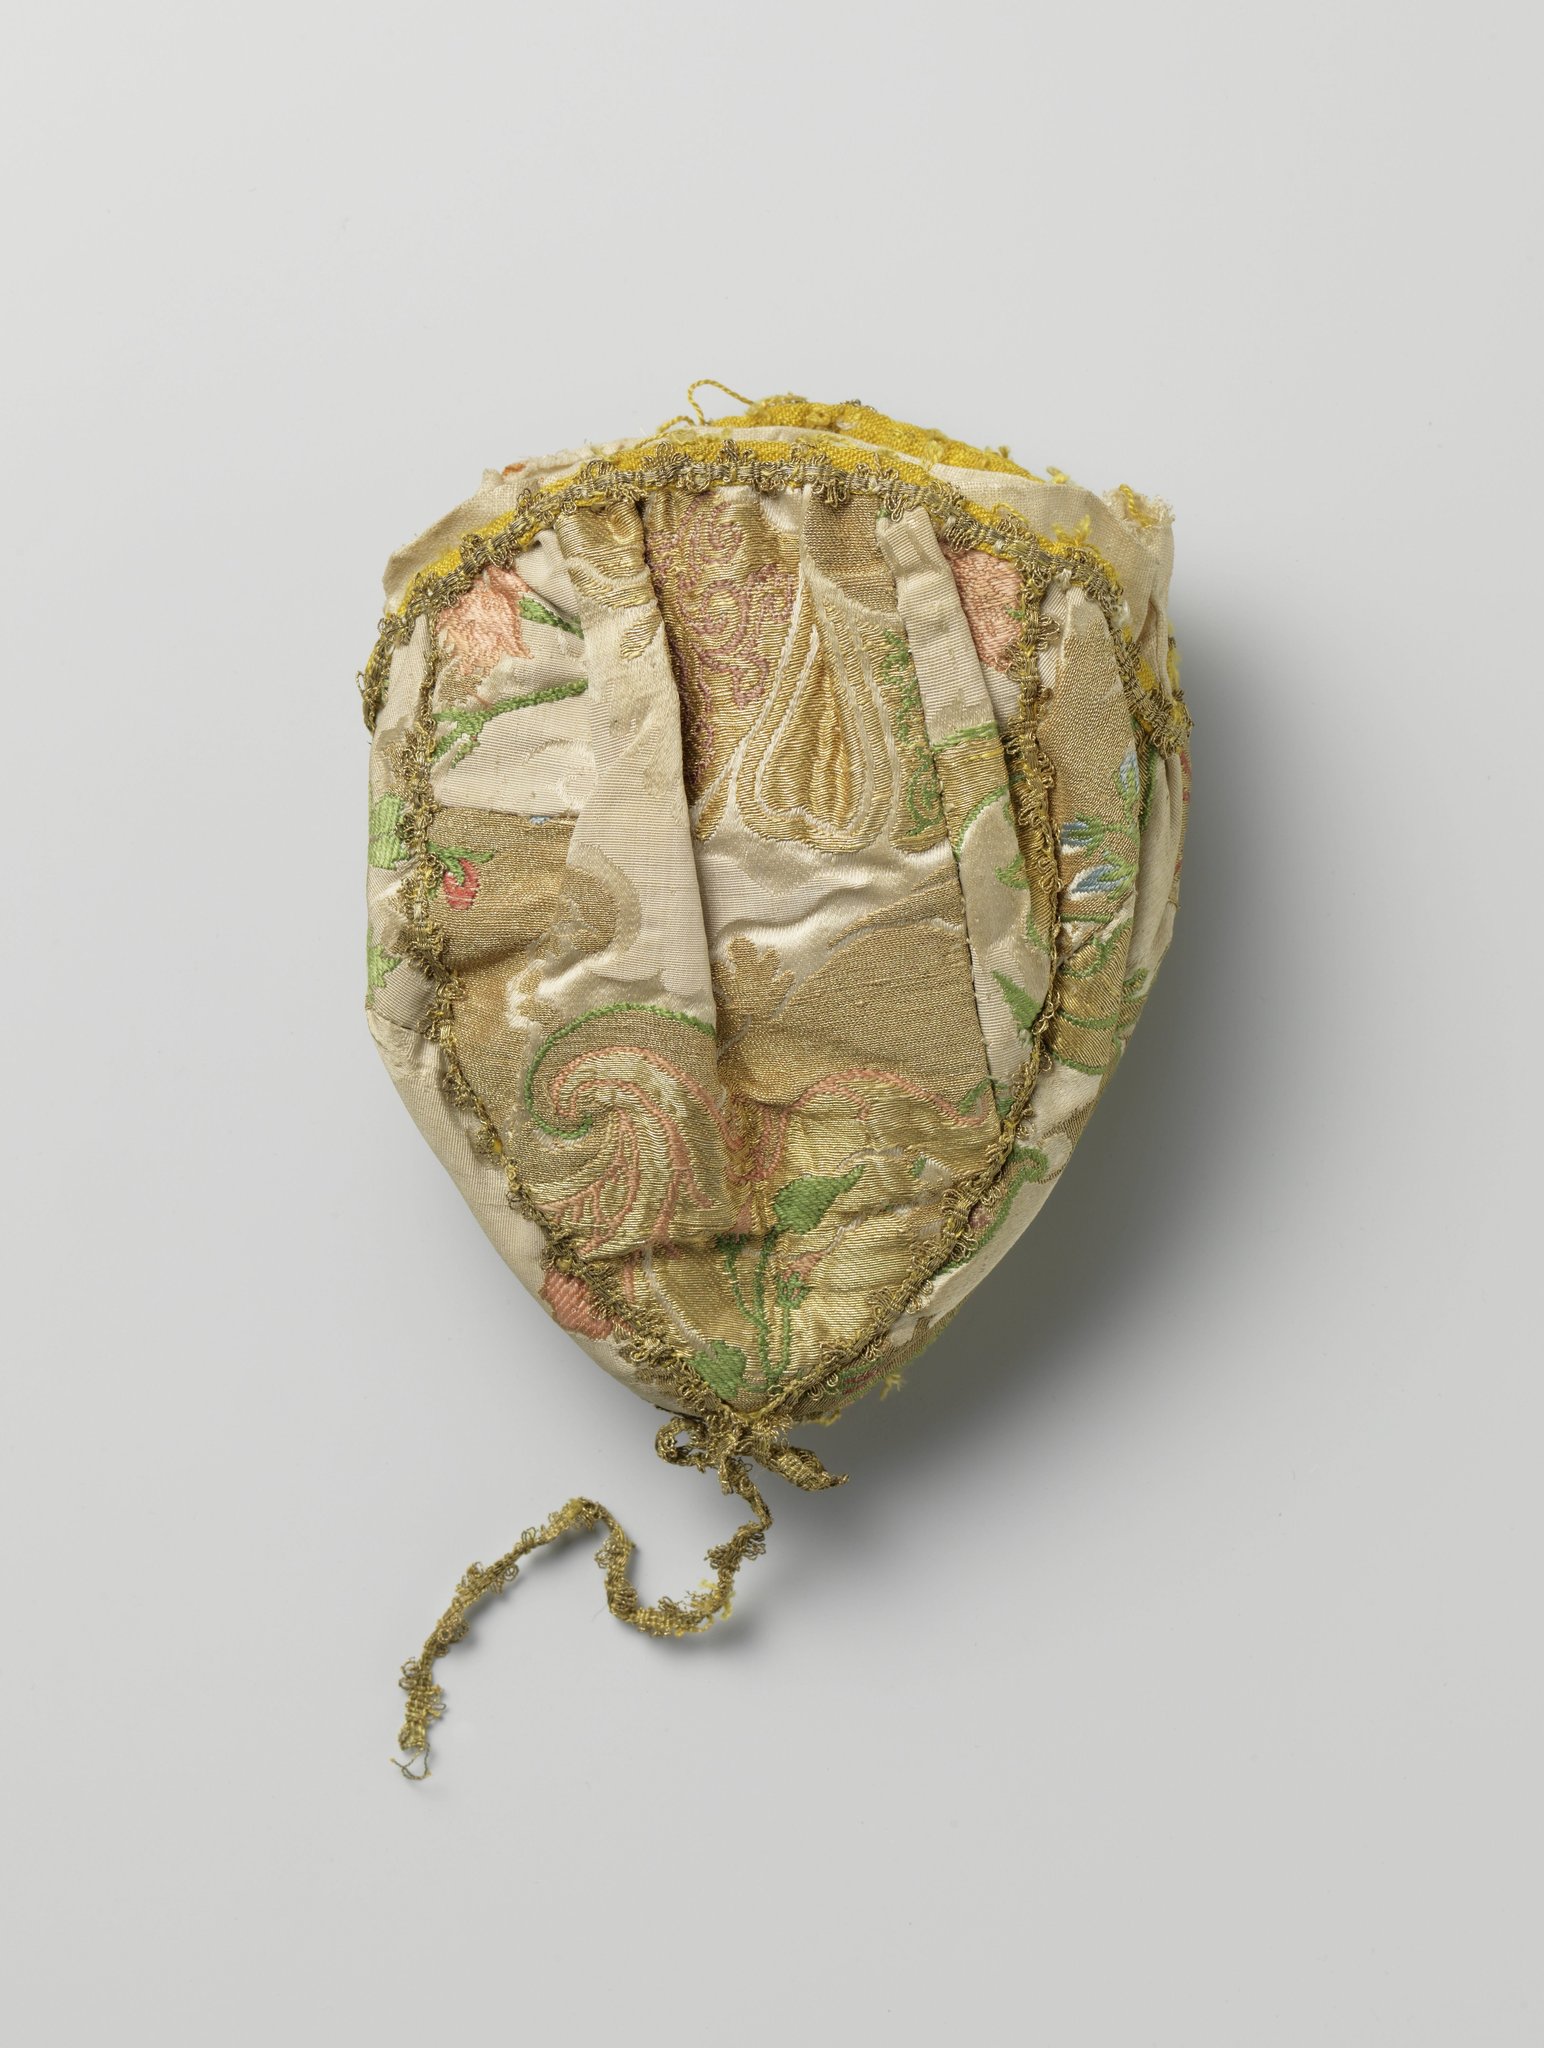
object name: purse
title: Buidel van goudbrokaat in een groot bloemenpatroon, op beigekleurig satijn, afgezet met goudgalon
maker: Anonymous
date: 1785-1800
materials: leather, linen, silk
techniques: brocade, tanning, weave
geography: western europe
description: Buidel, bestaande uit vier pattes van goudbrokaat met accenten in groen, roze en blauw, in een groot bloemenpatroon, op beigekleurig satijn. De bovenrand en de naden zijn afgezet met goudgalon, die een strik vormt aan de onderkant. Binnenin een opgestikt geel vak van zeemleer en een voering van geglanst linnen, dat slechts langs twee kanten vastzit. Geen hengsel.